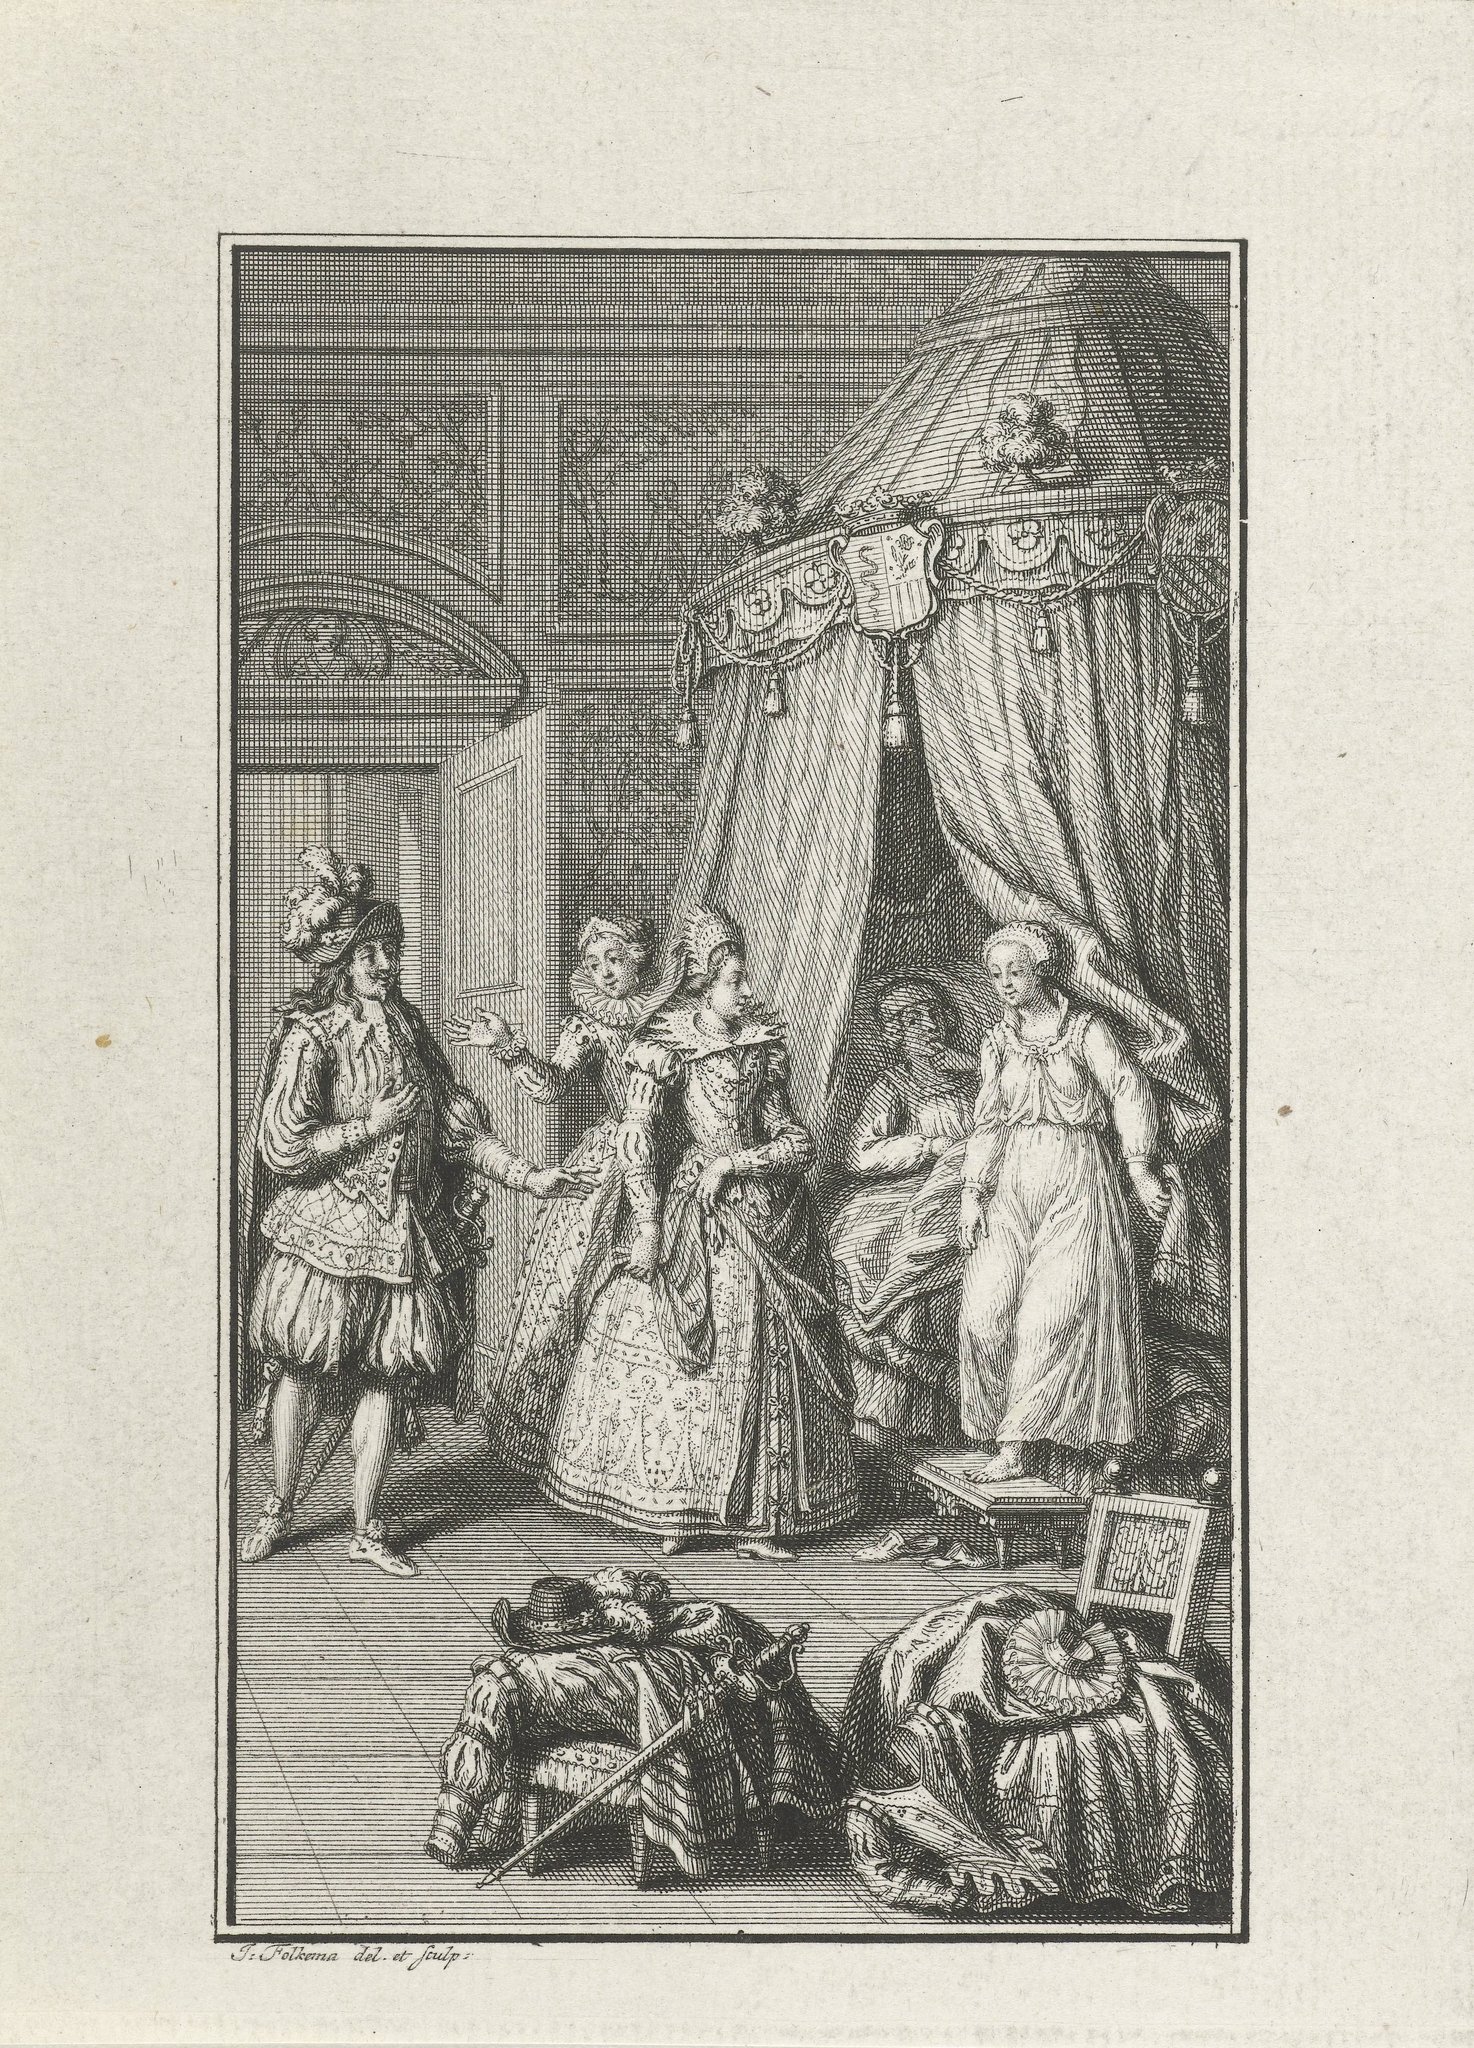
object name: print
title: Liefdespaar betrapt in een slaapvertrek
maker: jacob folkema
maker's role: draughtsman, print maker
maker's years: 1692-1767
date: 1702-1767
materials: paper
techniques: etching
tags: interrupted meeting, lovers caught by surprise, bedroom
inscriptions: collector's mark: Lugt 2228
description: Drie rijk geklede figuren zijn een slaapvertrek binnengegaan en treffen daar in bed een man en vrouw. De man is in bed blijven liggen terwijl de vrouw in nachthemd uit bed is gestapt. Op de voorgrond ligt uitgetrokken kleding over een stoel en een krukje.